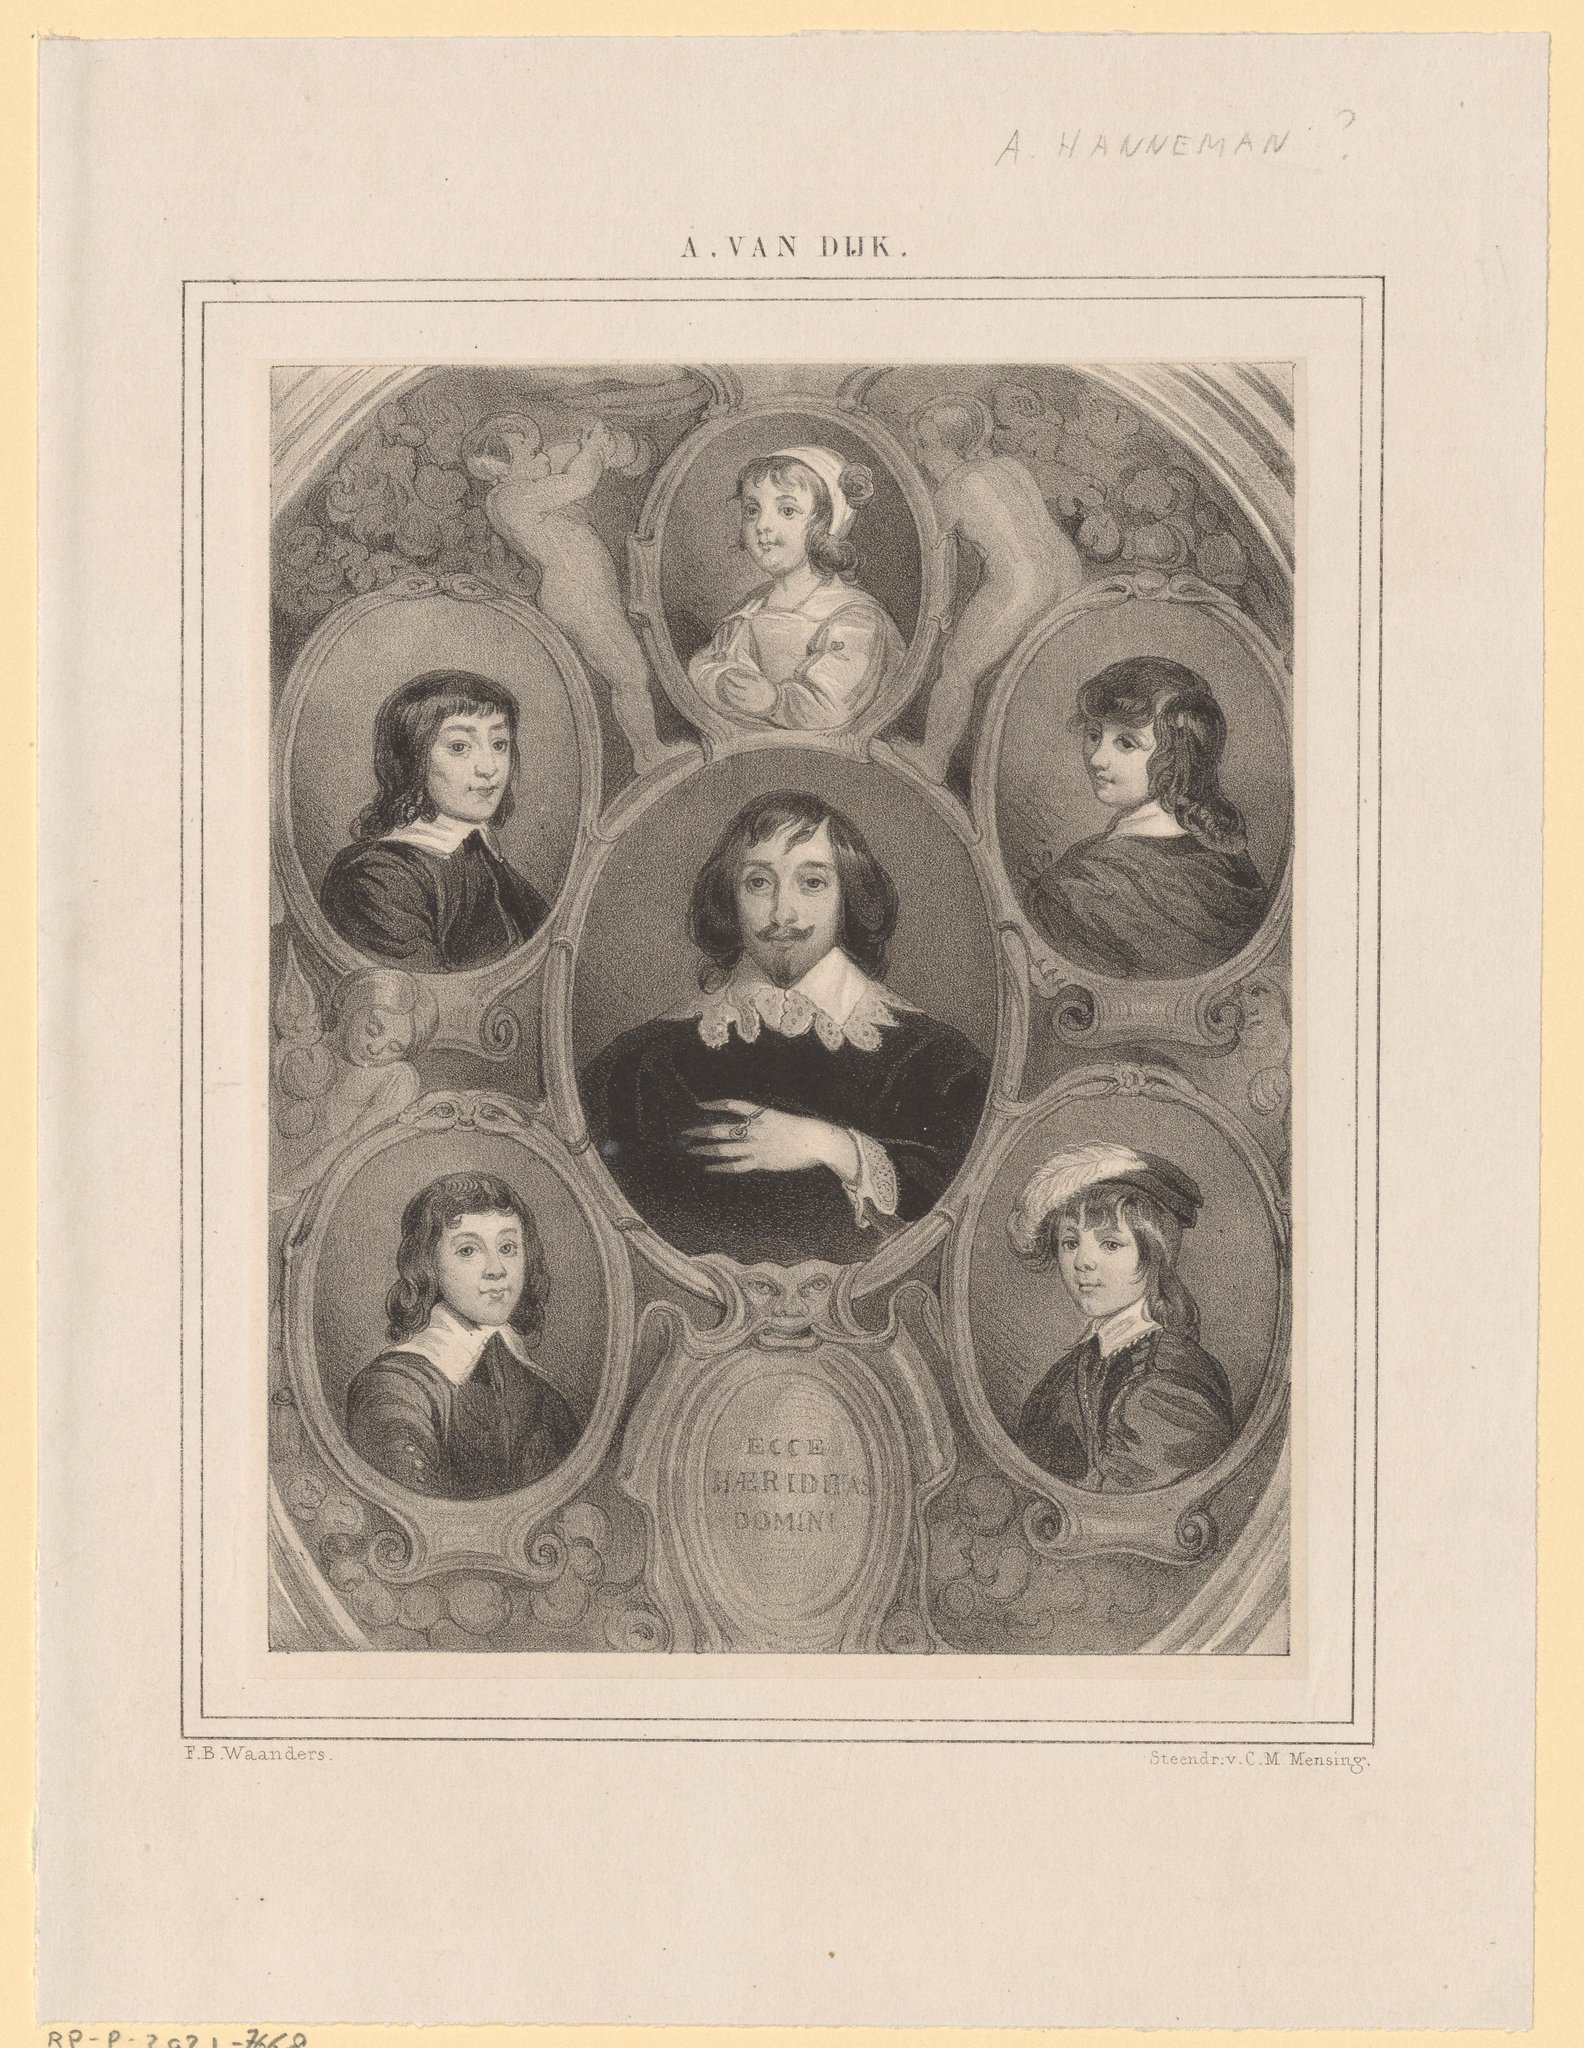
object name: print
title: Portretten van Constantijn Huygens en zijn vijf kinderen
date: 1847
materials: paper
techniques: lithograph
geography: the hague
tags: constantijn huygens (i), the hague, draughtsman, physicist, christiaan huygens (ii), susanna huygens, constantijn huygens (ii), philips huygens, historical persons - bb - woman, historical persons